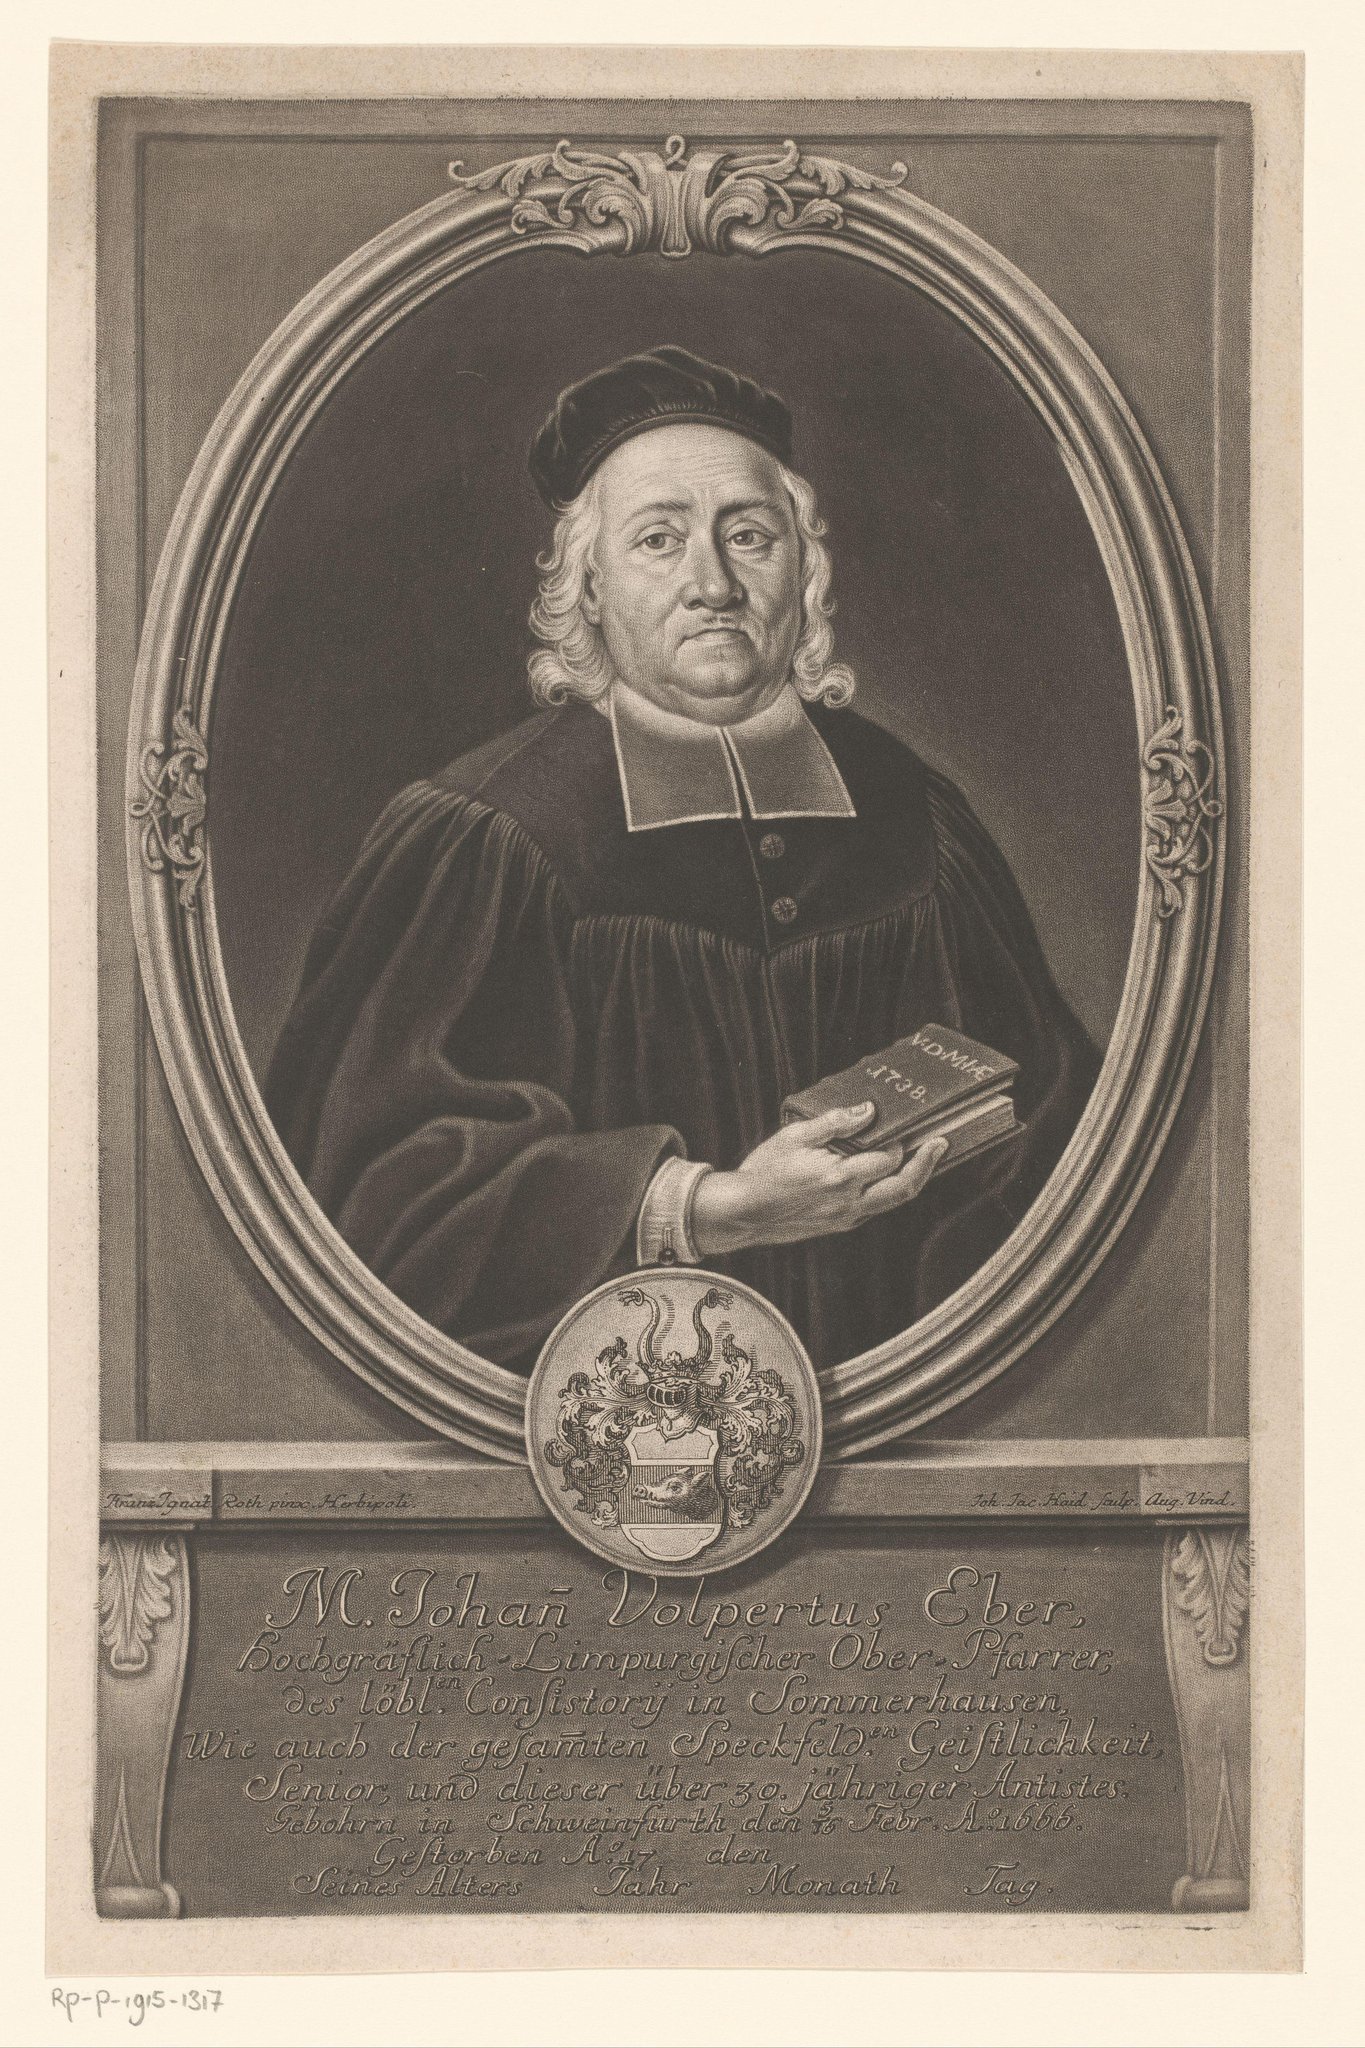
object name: print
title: Portret van Johann Volpert Eber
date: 1738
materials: paper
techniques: etching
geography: augsburg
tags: theologian, historical persons, book, armorial bearing, heraldry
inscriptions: collector's mark: Lugt 2228